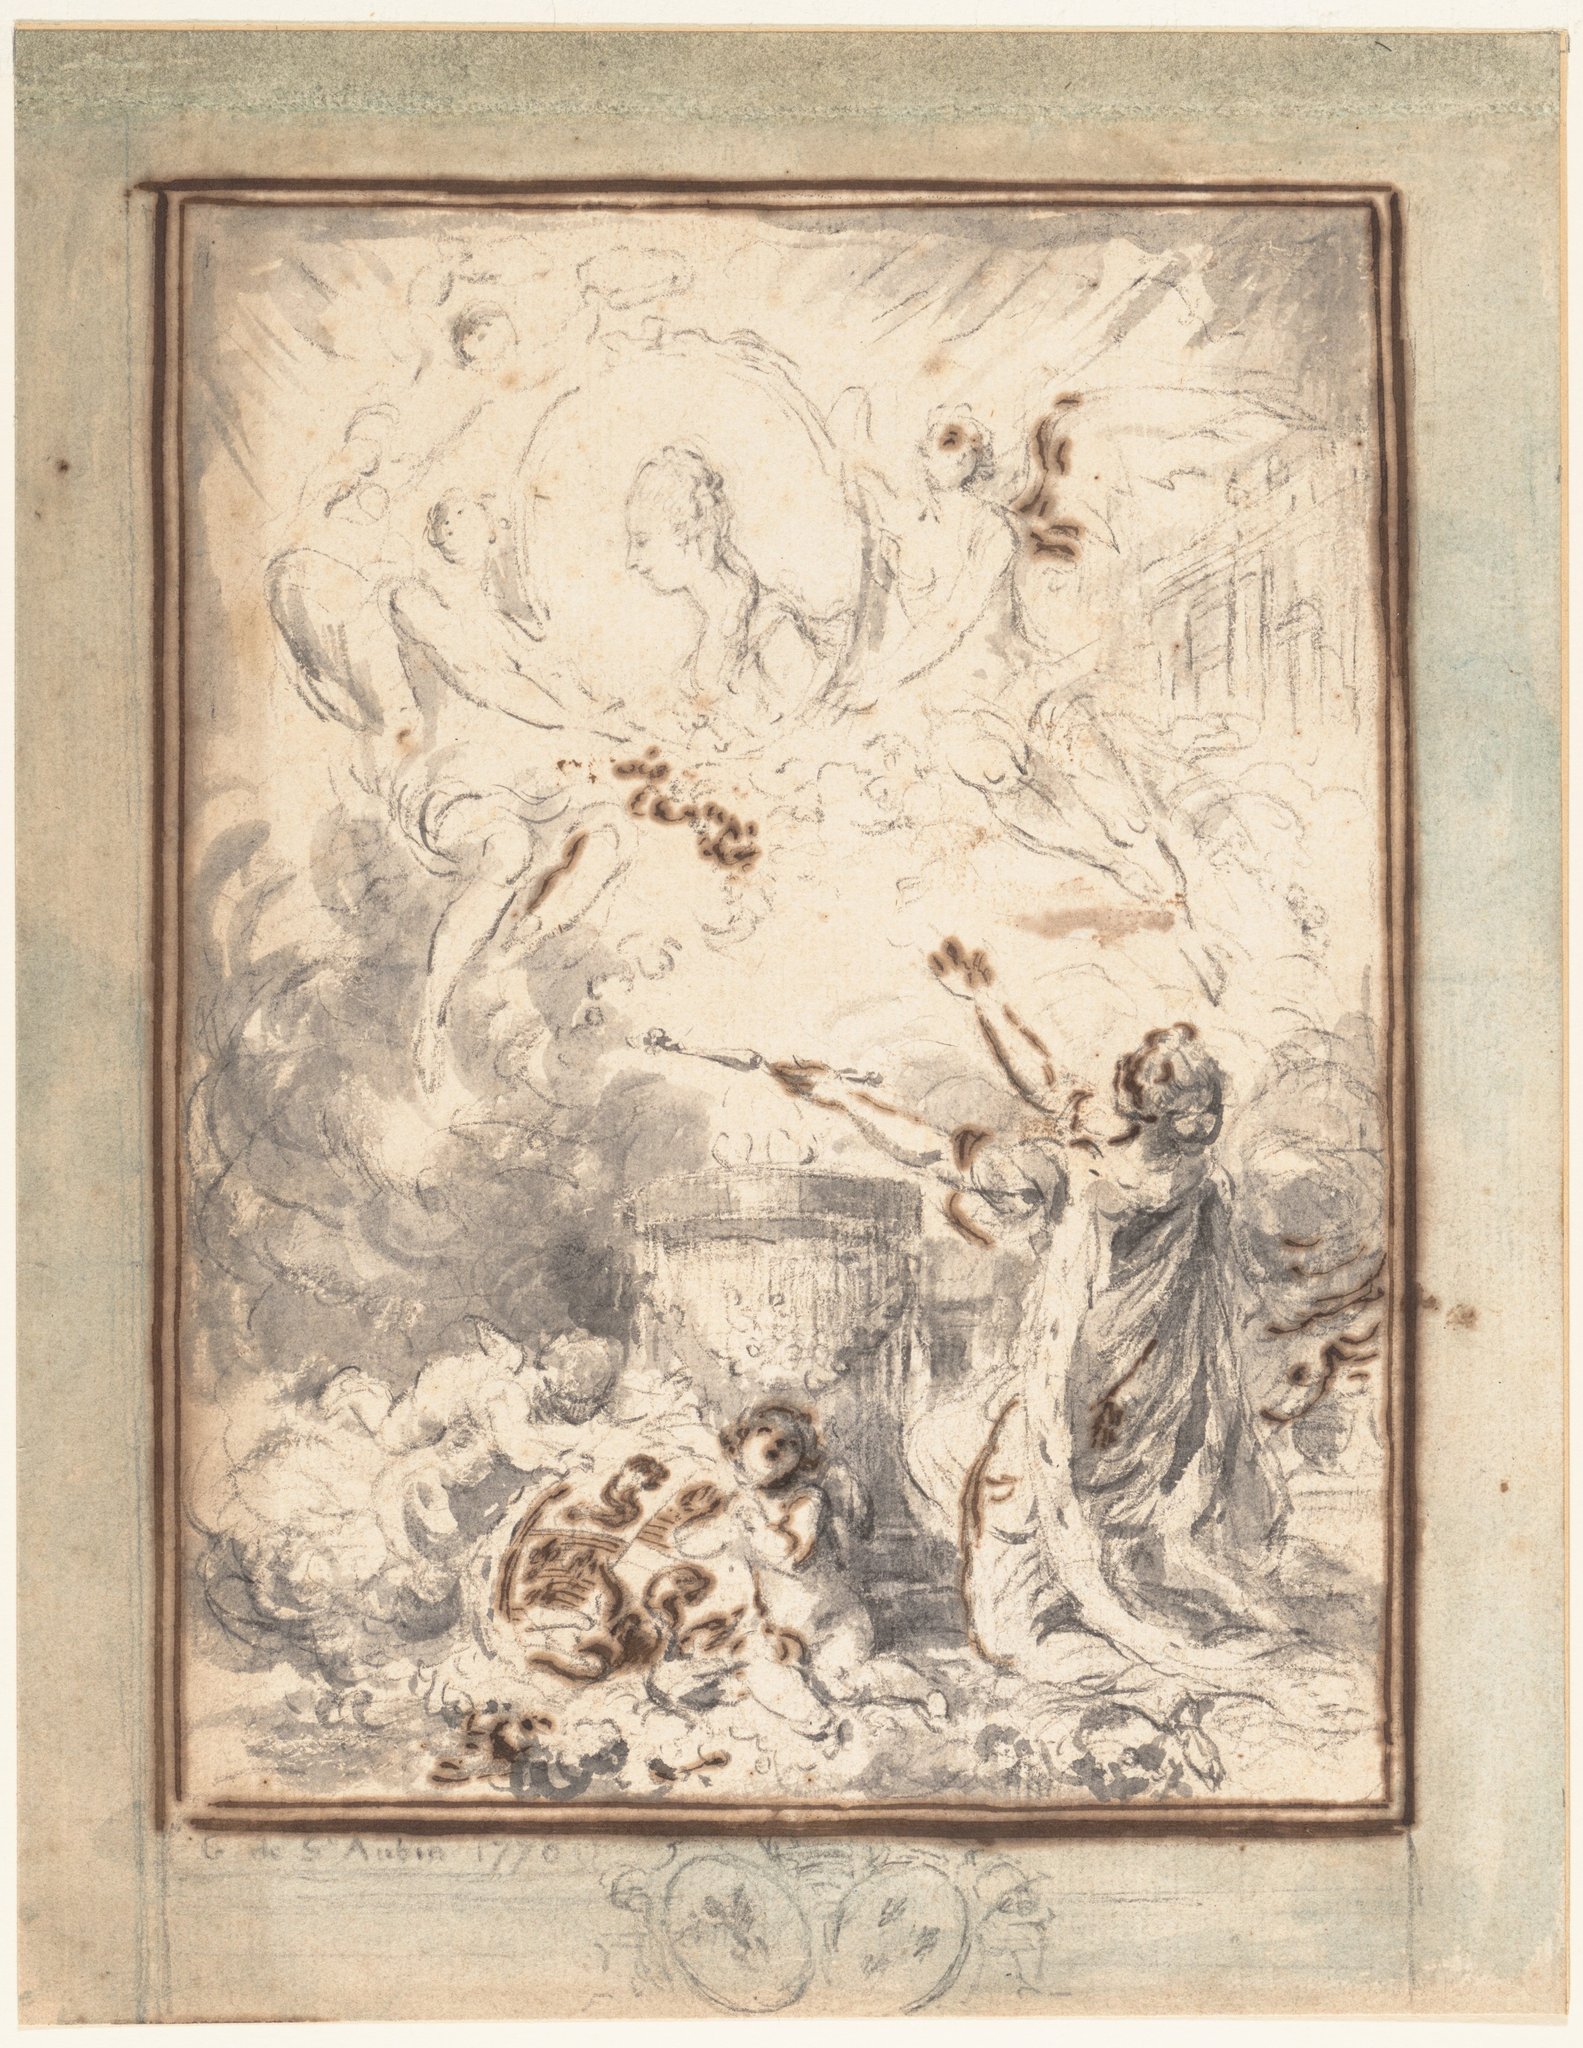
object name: drawing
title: Allegory of the Marriage of the Dauphin and Marie-Antoinette in 1770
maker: gabriel de saint-aubin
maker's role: artist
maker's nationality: french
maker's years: 1724-1780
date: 1770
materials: chalk, ink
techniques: brush, pen, tinting, wash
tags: women